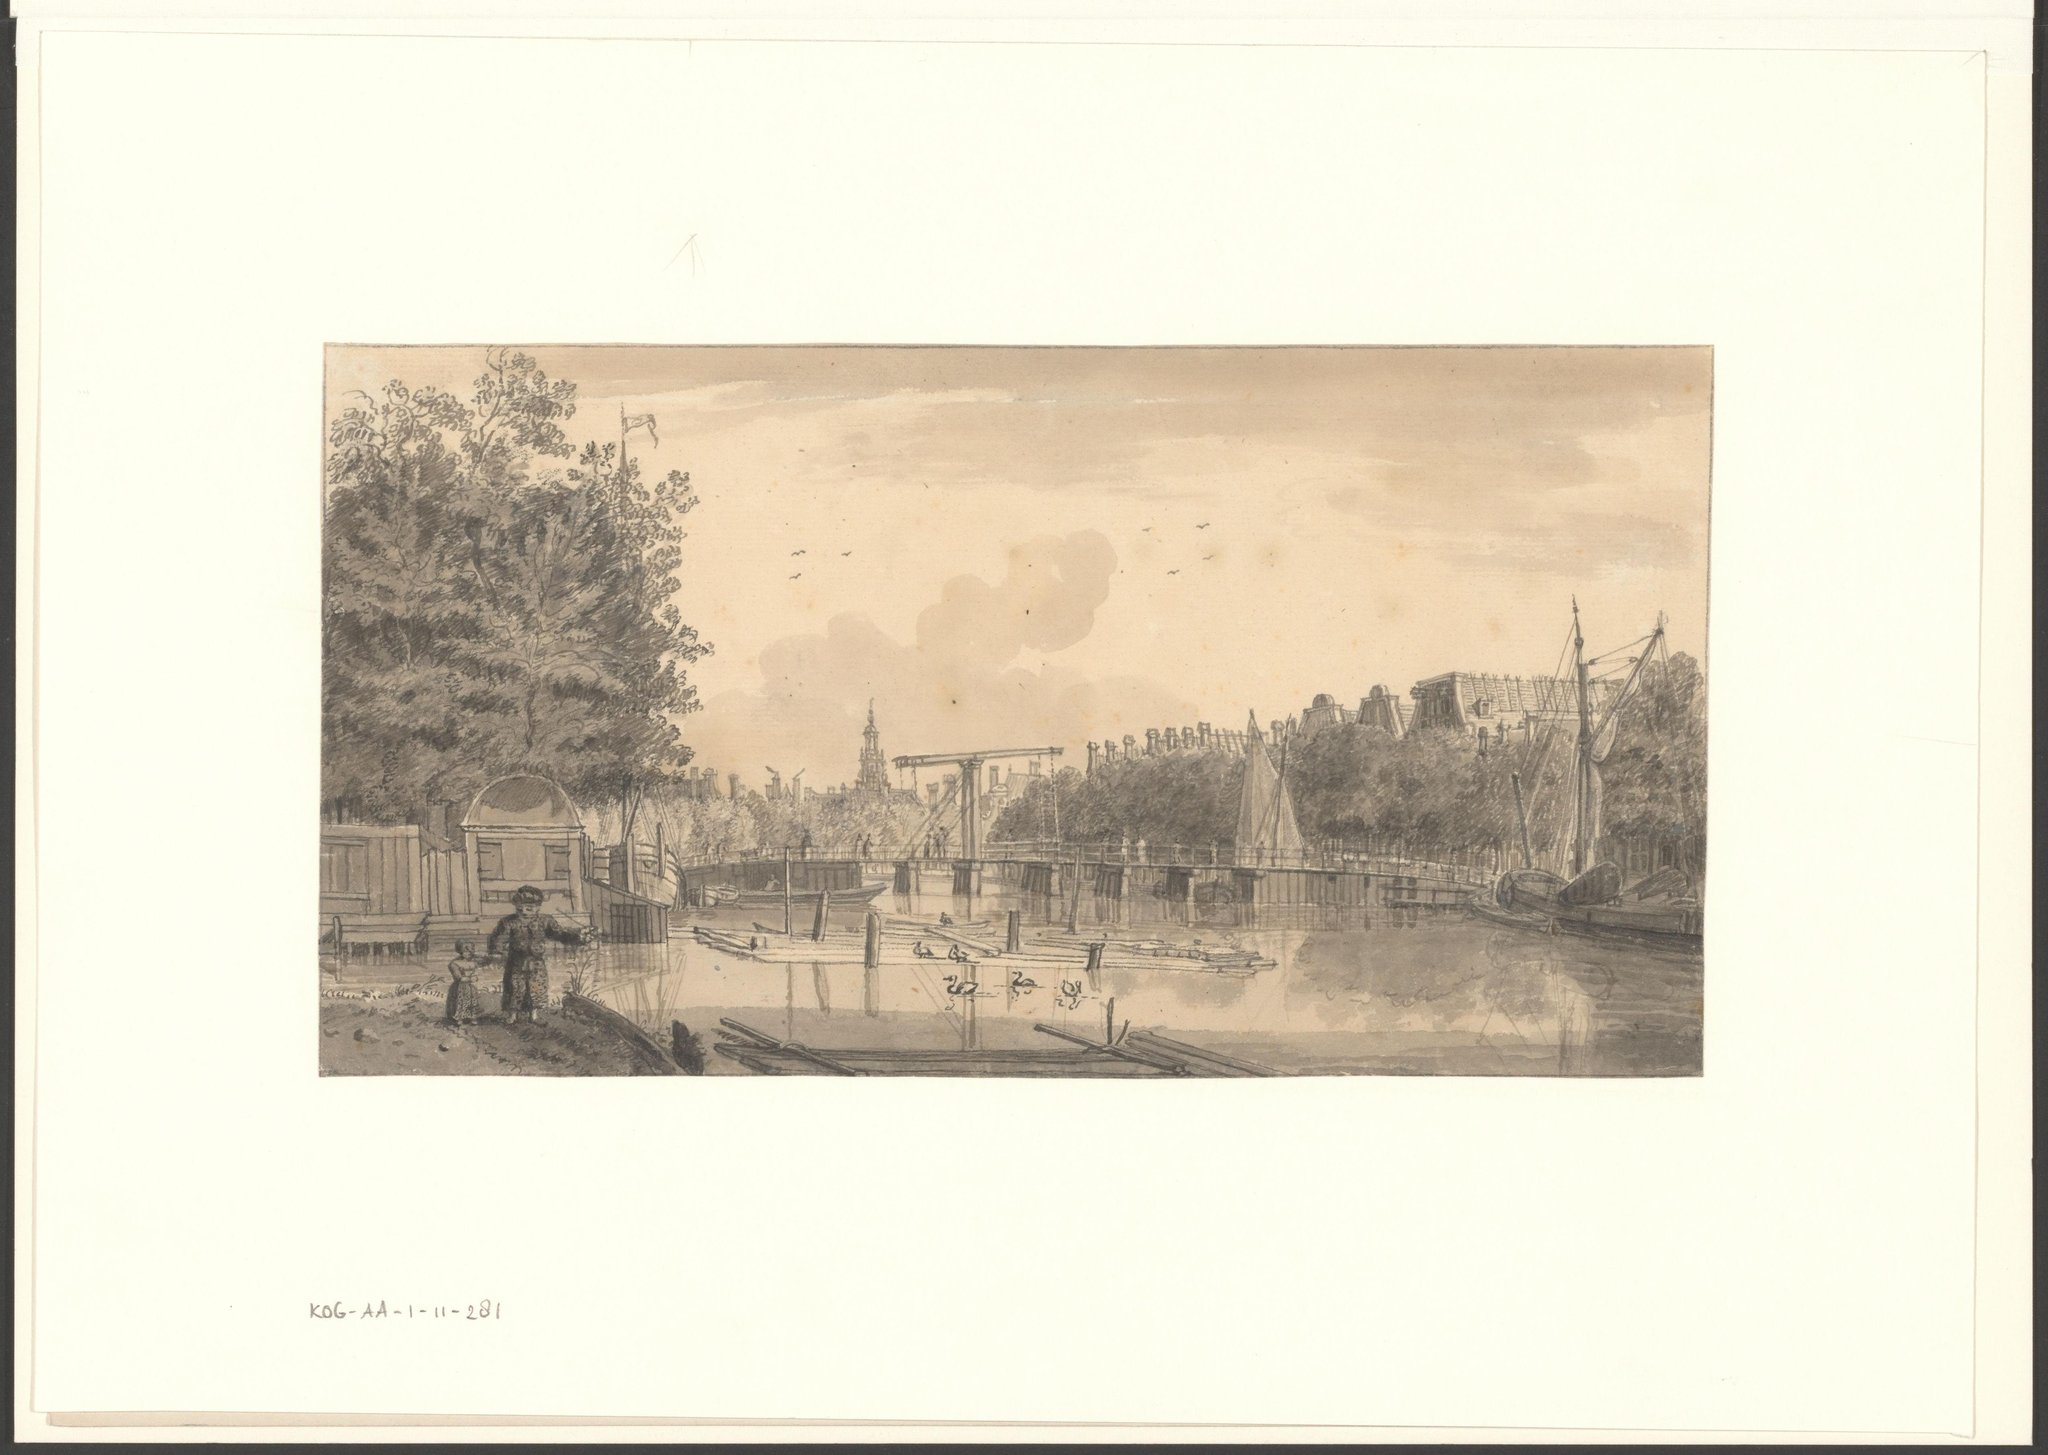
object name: drawing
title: Gezicht op de Rapenburgergracht, gezien richting de Montelbaanstoren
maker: Anonymous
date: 1750-1850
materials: ink, paper, pencil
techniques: brush, pen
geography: amsterdam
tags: tower, clock tower ~ monumental adornment, city-view in general; 'veduta', canal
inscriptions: inscription: ‘Port. 11-281’, stamp: ‘Van het Koninklijk / Oudheidkundig Genootschap / te Amsterdam.’, inscription: ‘Rapenburgergracht / thans [...]Entrepot (...) naar den K[...]ijk.’, collector's mark: ‘11’ Lugt 1641b, inscription: ‘van Rapenburg of vinkebuurt’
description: Onderwerpsrubriek binnen de Atlas Amsterdam: Raadhuisstraat, Raamgracht, Raamplein, Rapenburgerstraat, Reguliersgracht, Reguliersbreestraat.